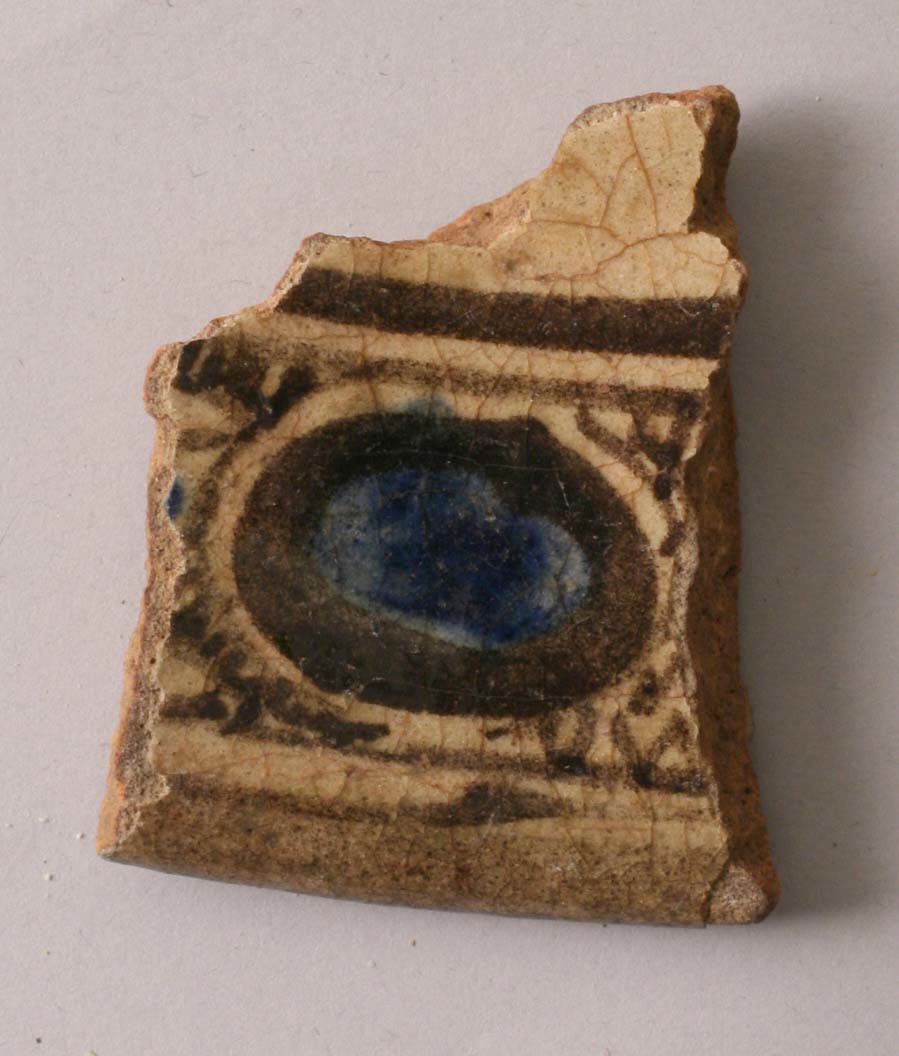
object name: fragment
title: Ceramic Fragment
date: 1301-1500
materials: earthenware, glaze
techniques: painting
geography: egypt